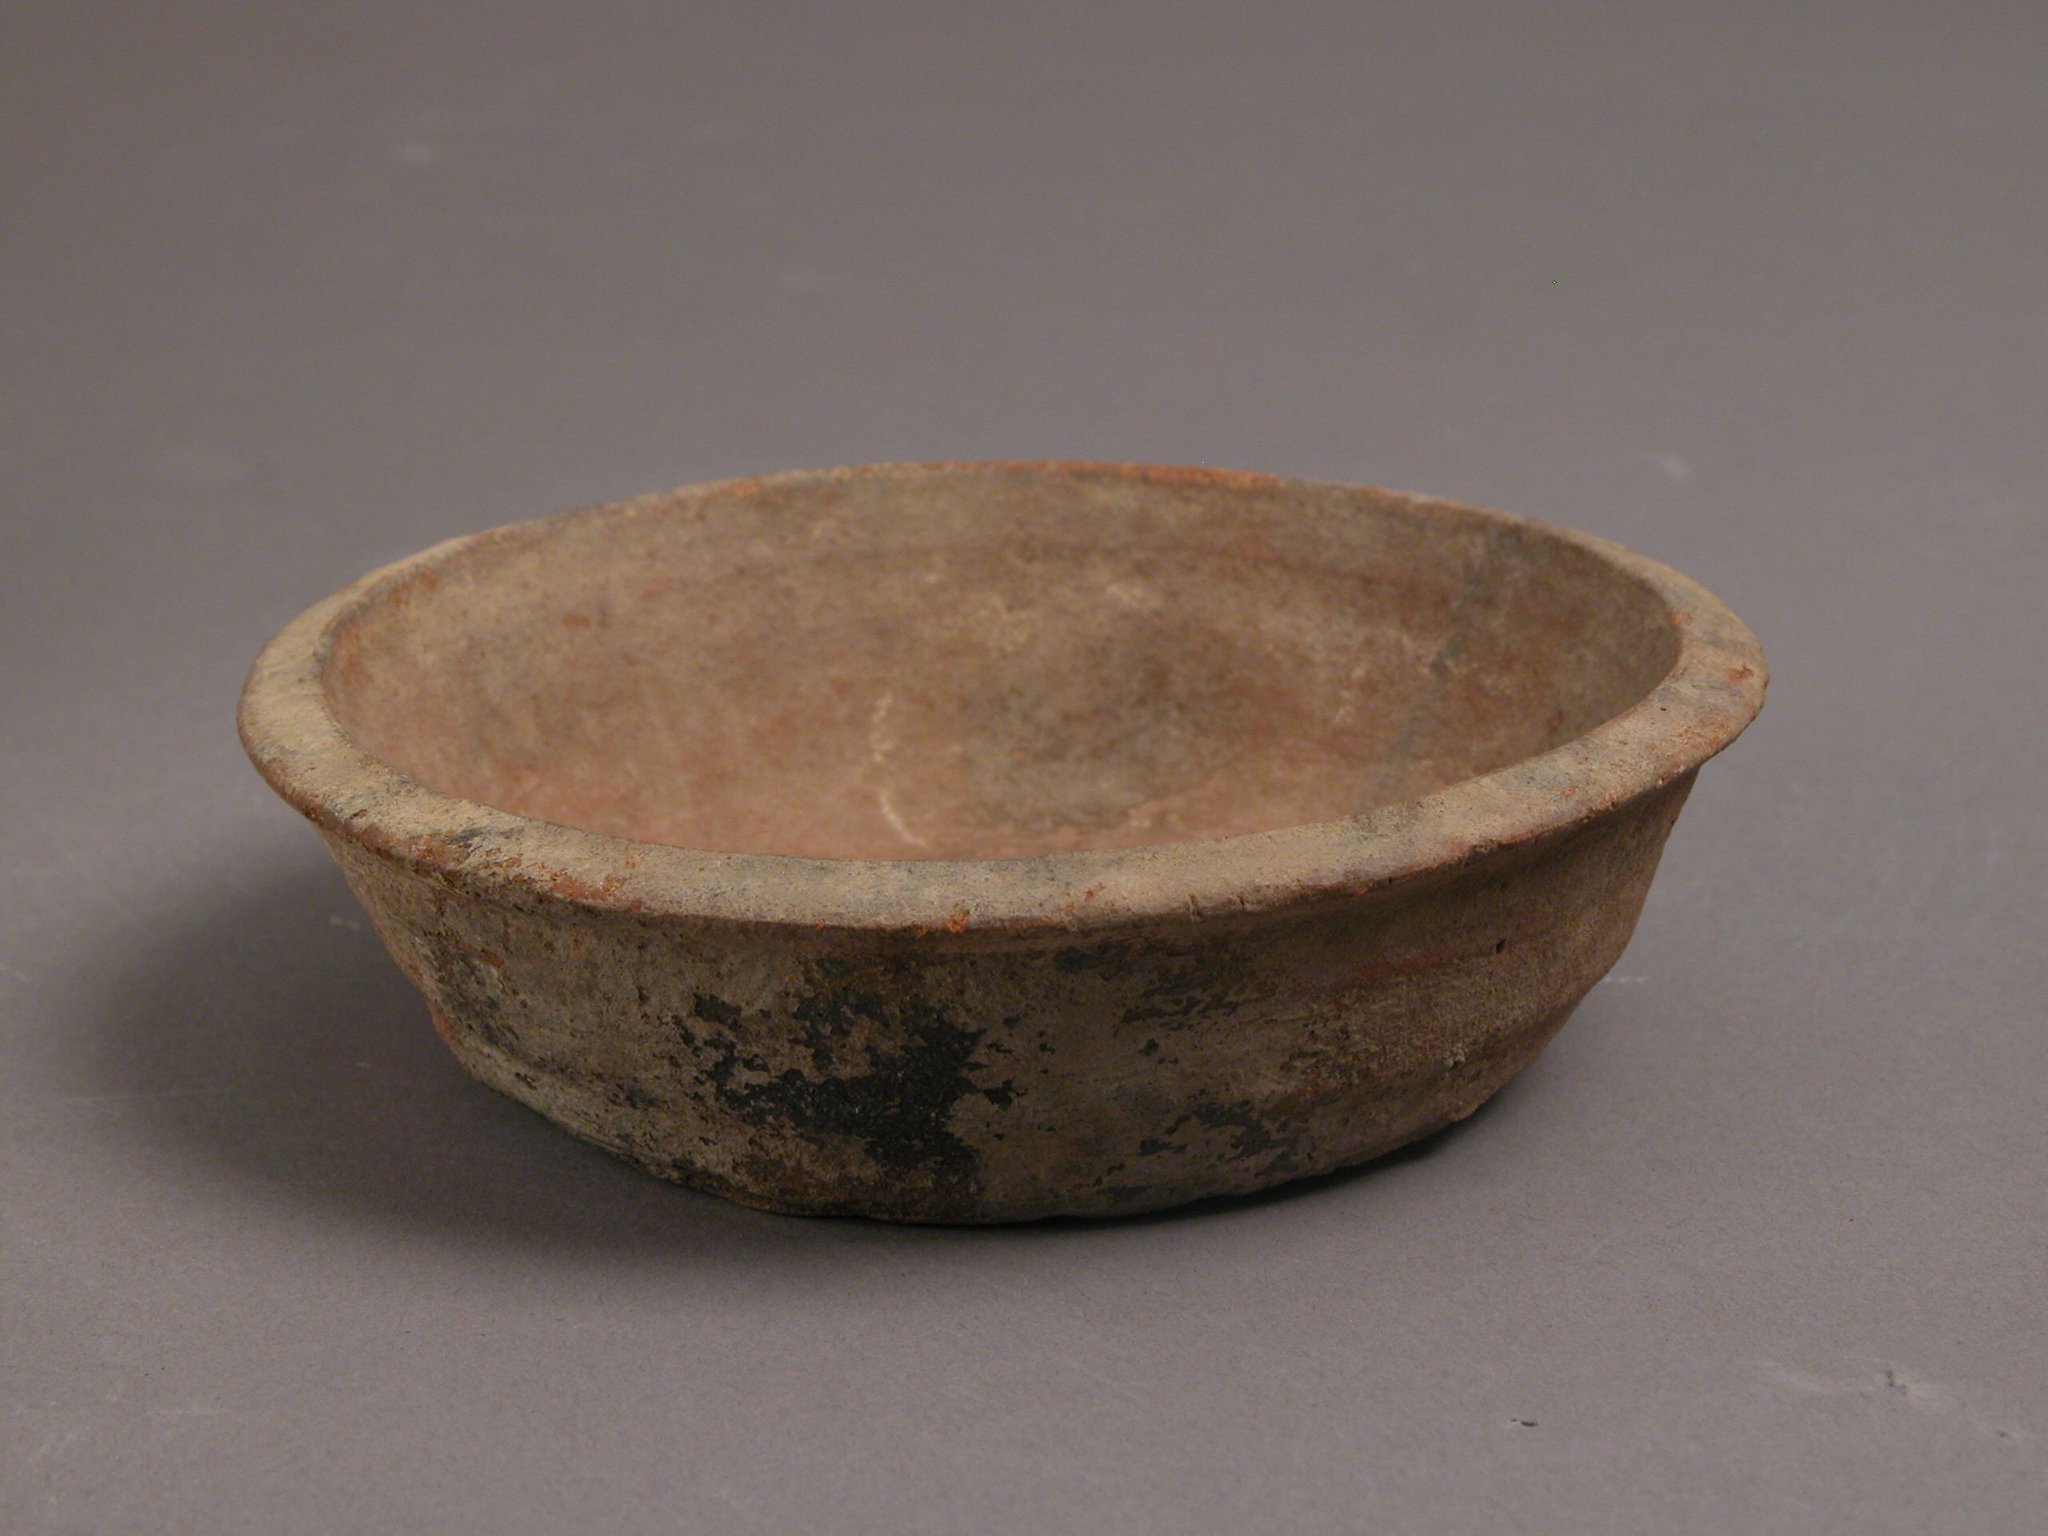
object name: bowl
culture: coptic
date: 301-700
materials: earthenware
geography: egypt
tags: bowls